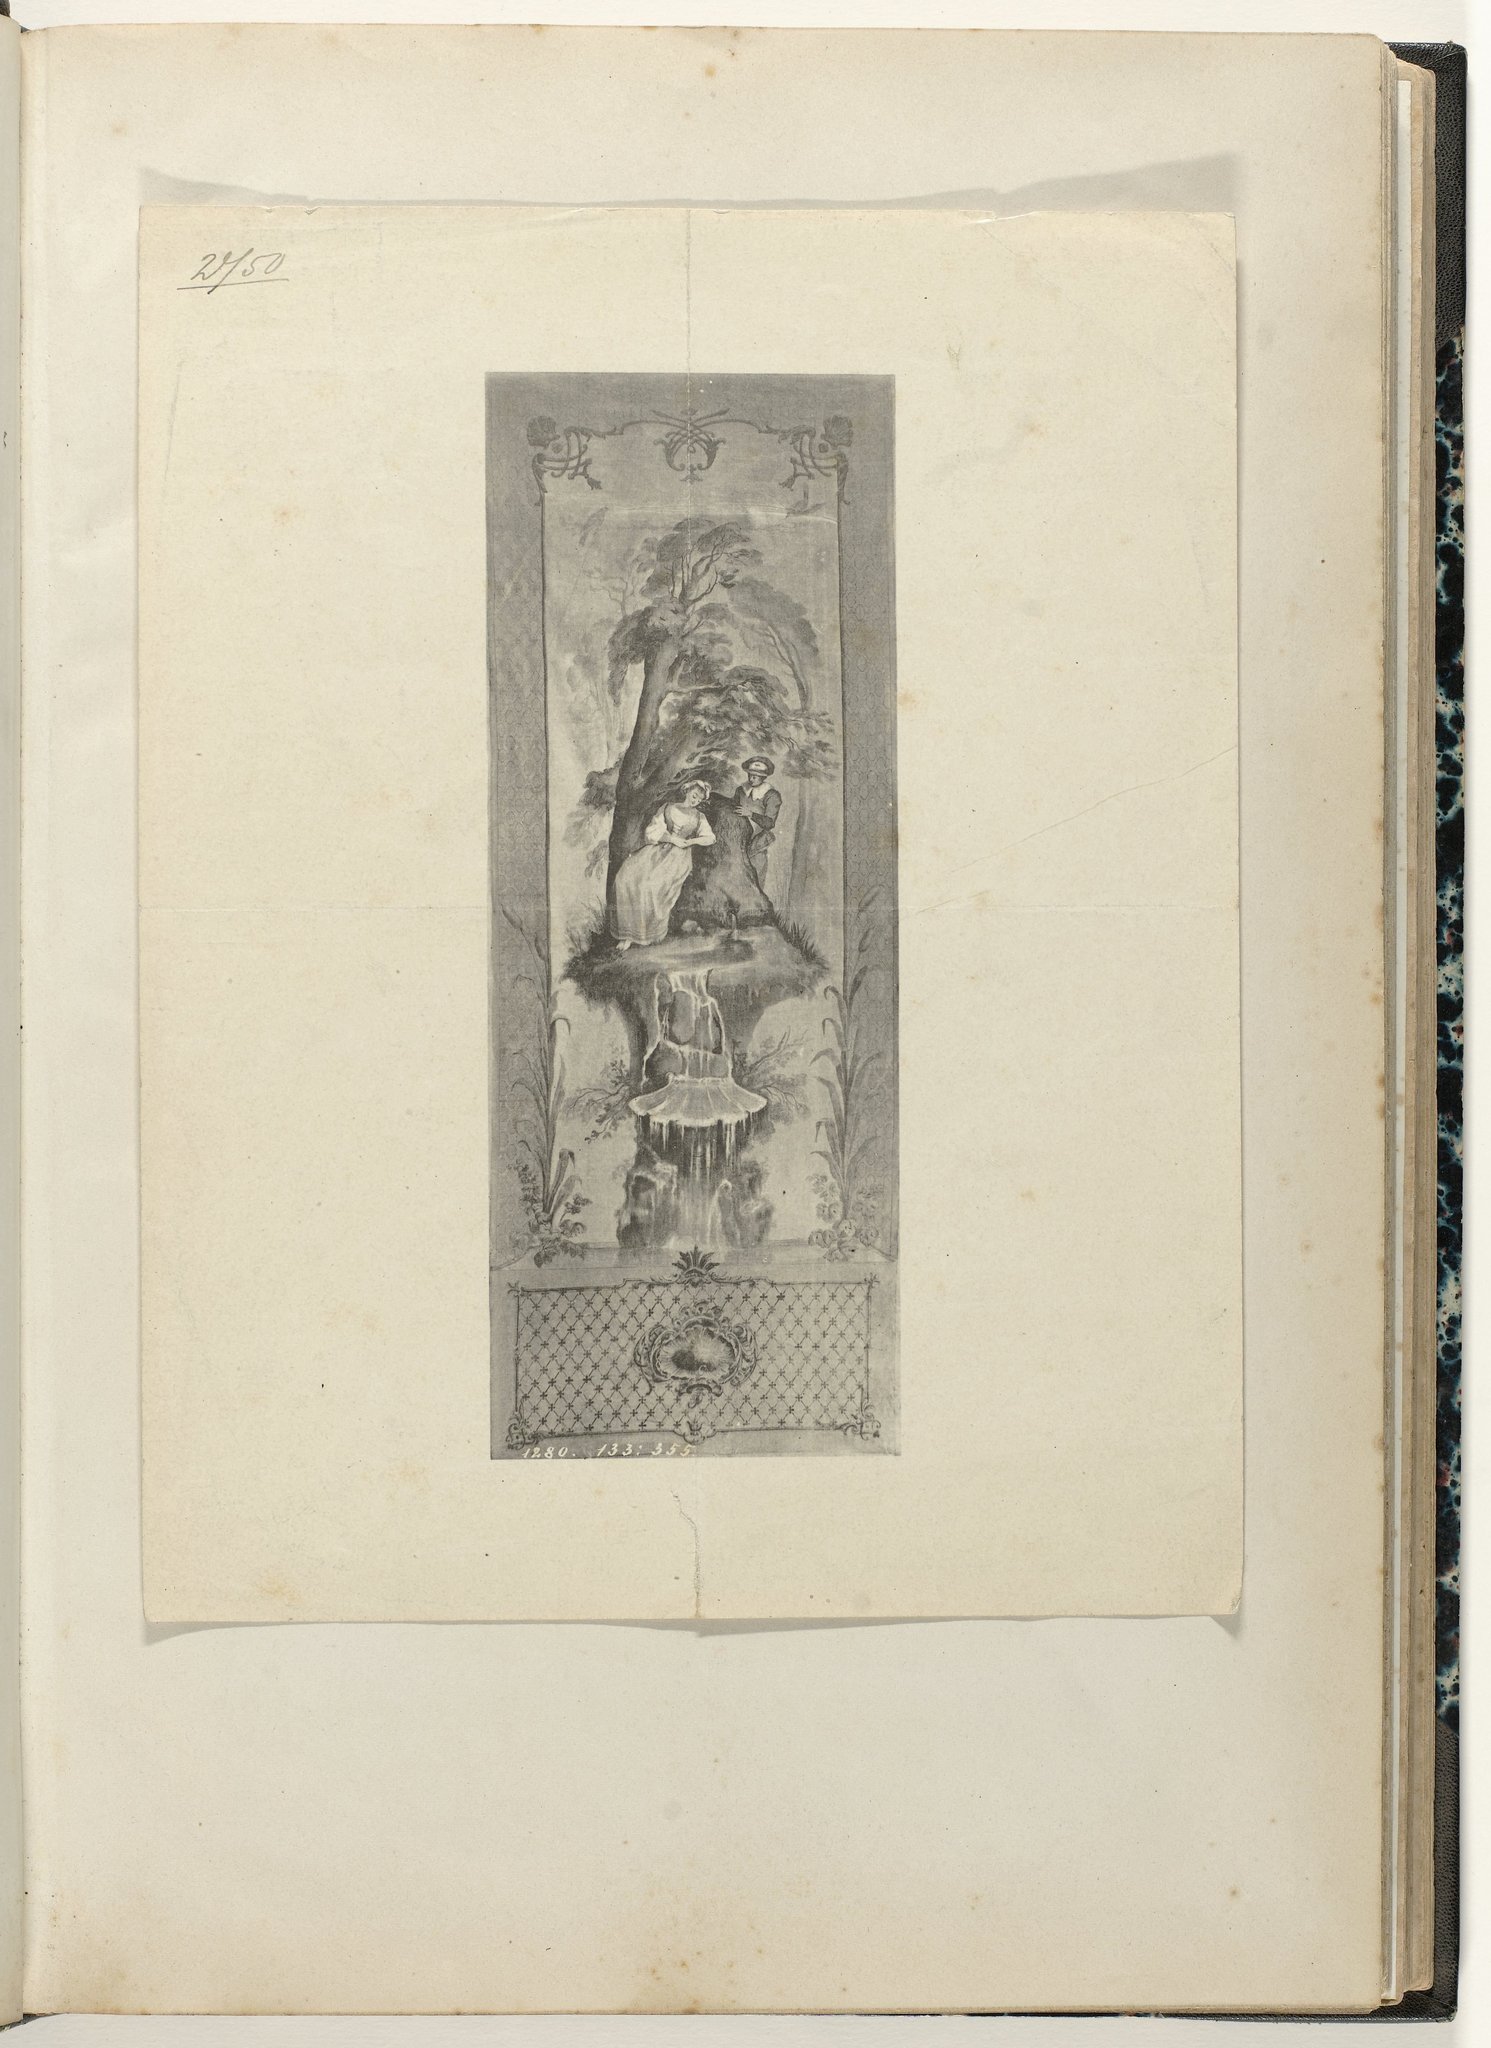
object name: photograph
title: Paneel met man en vrouw bij waterval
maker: Anonymous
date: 1866-1900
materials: paper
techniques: printing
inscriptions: number: ‘2750’